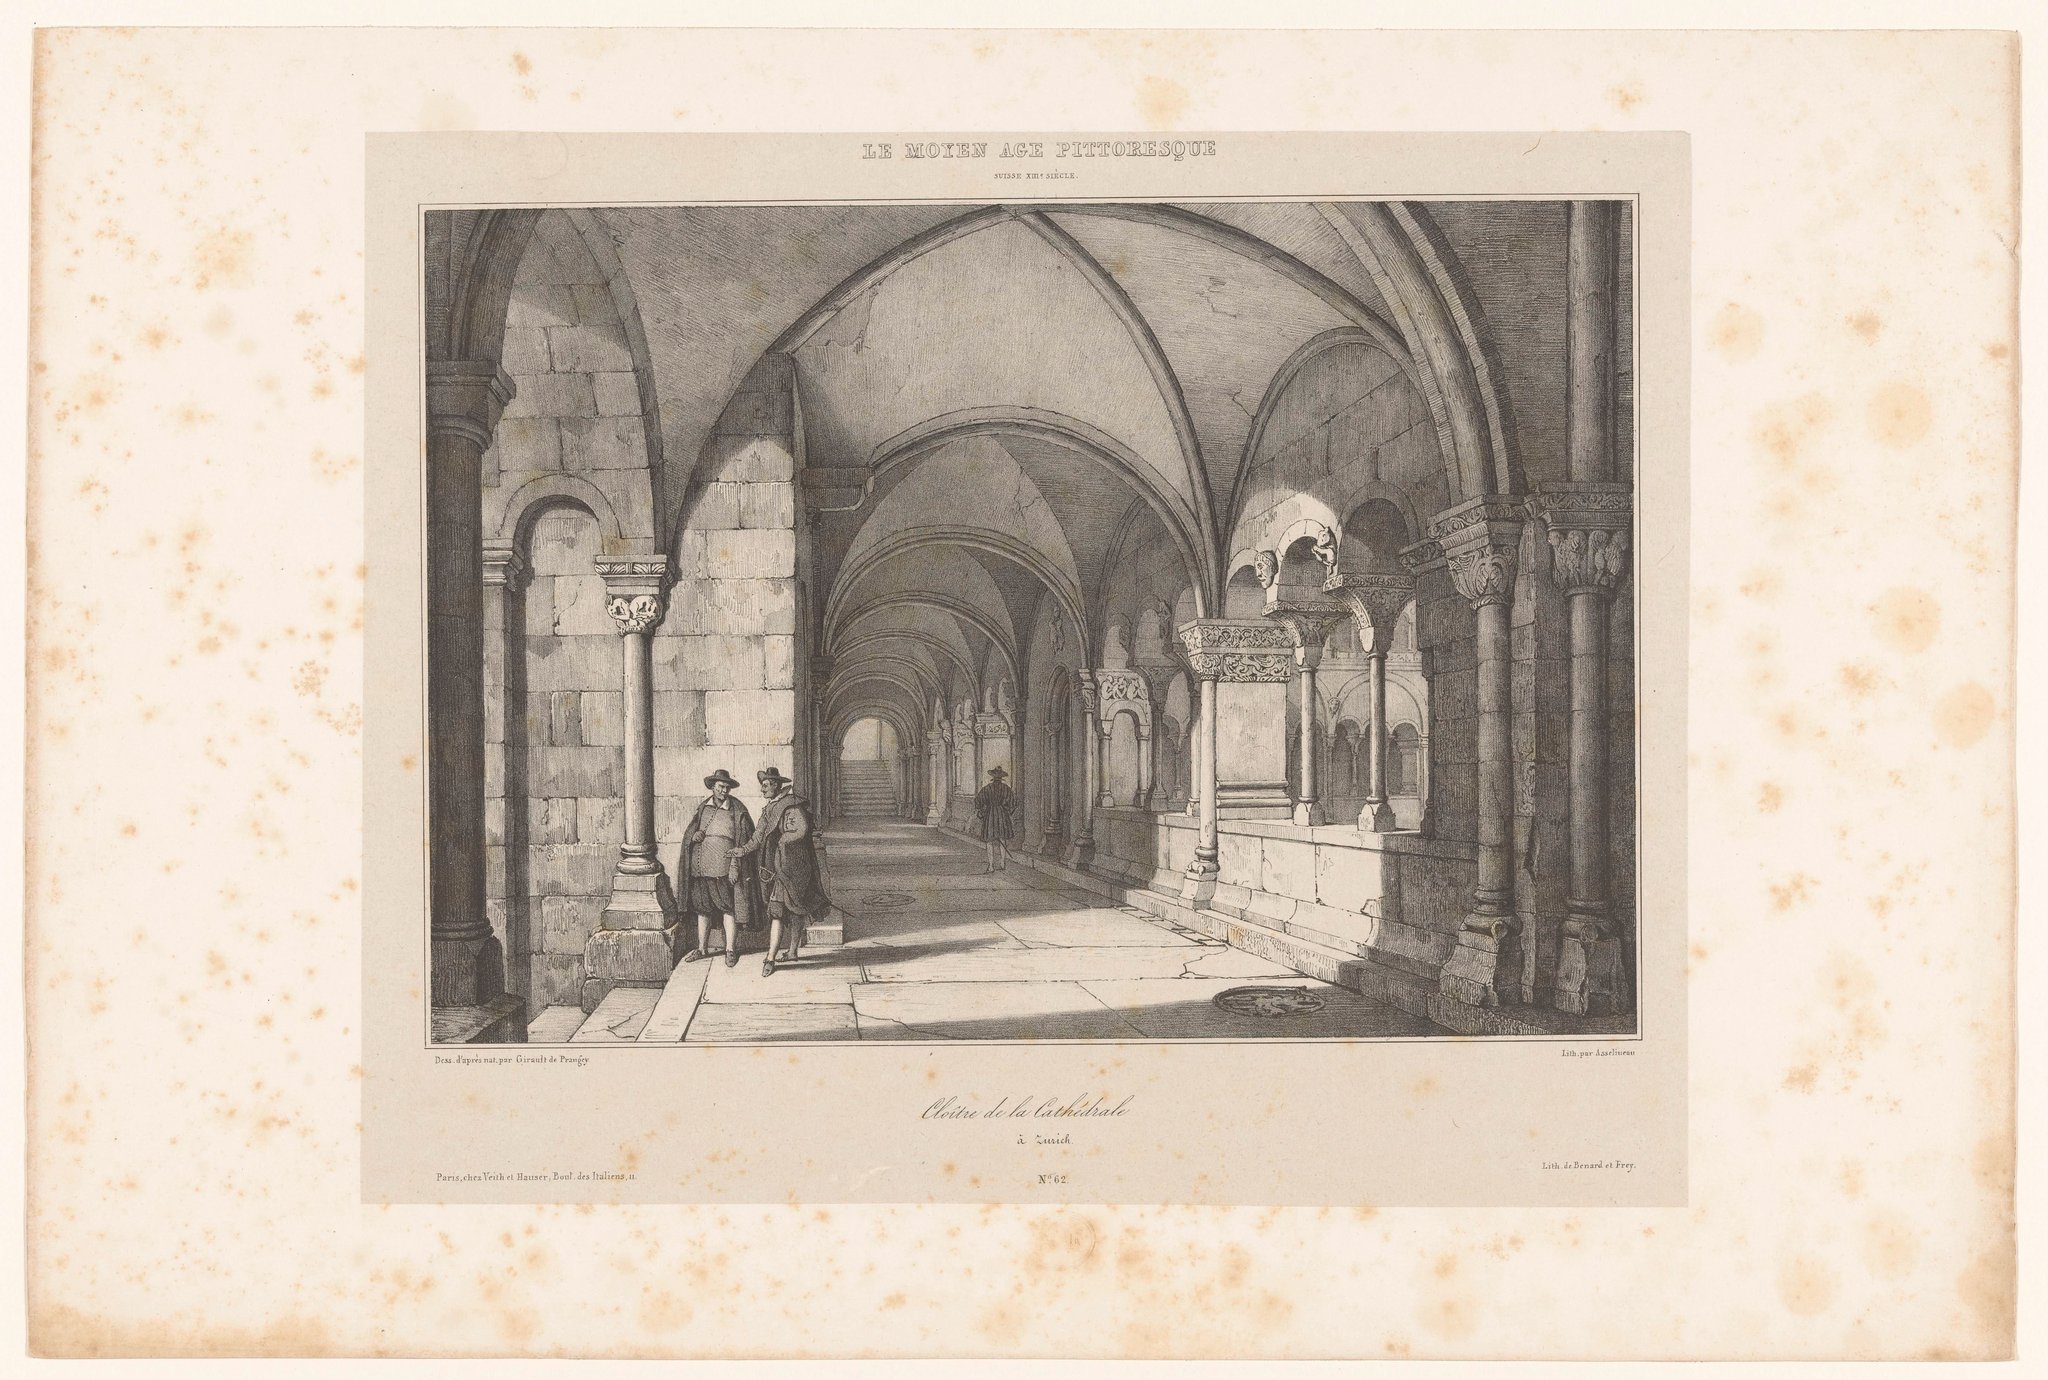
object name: print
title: Le Moyen Age pittoresque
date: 1837-1839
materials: paper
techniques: lithograph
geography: paris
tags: parts of church interior: ambulatory, cloisters ~ monastery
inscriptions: collector's mark: Lugt 2228, check stamp: Lugt 4211